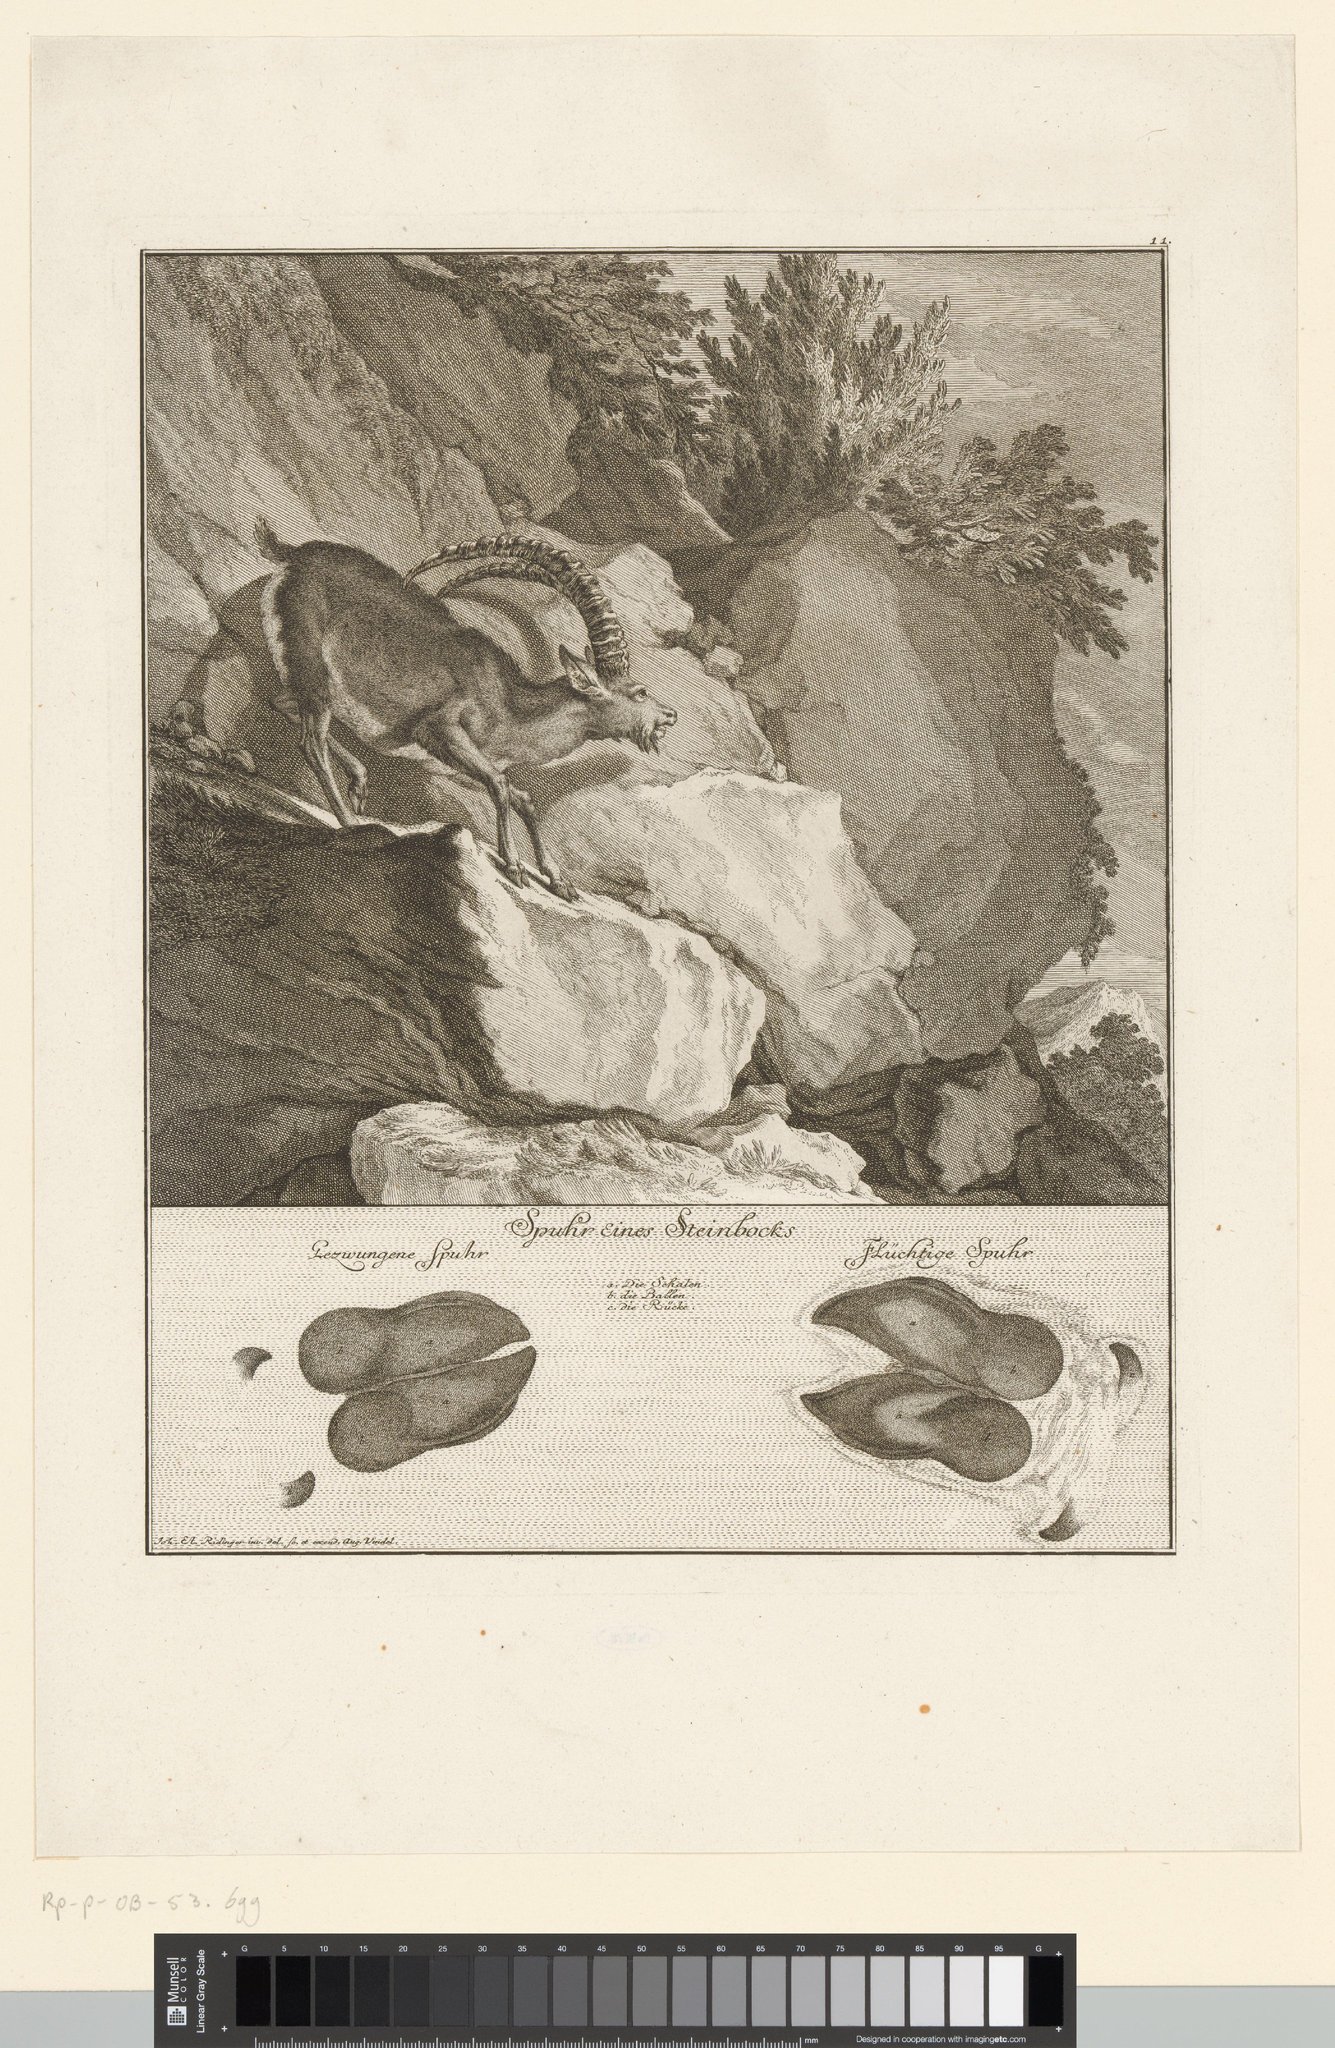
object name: print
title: Dieren met hun sporen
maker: johann elias ridinger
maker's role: draughtsman, painter, print maker, publisher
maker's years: 1698-1767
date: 1751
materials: paper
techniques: etching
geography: augsburg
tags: foot-print, track, hoofed animals: ibex, forest, wood, hunt ~ mammals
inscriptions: collector's mark: Lugt 2228